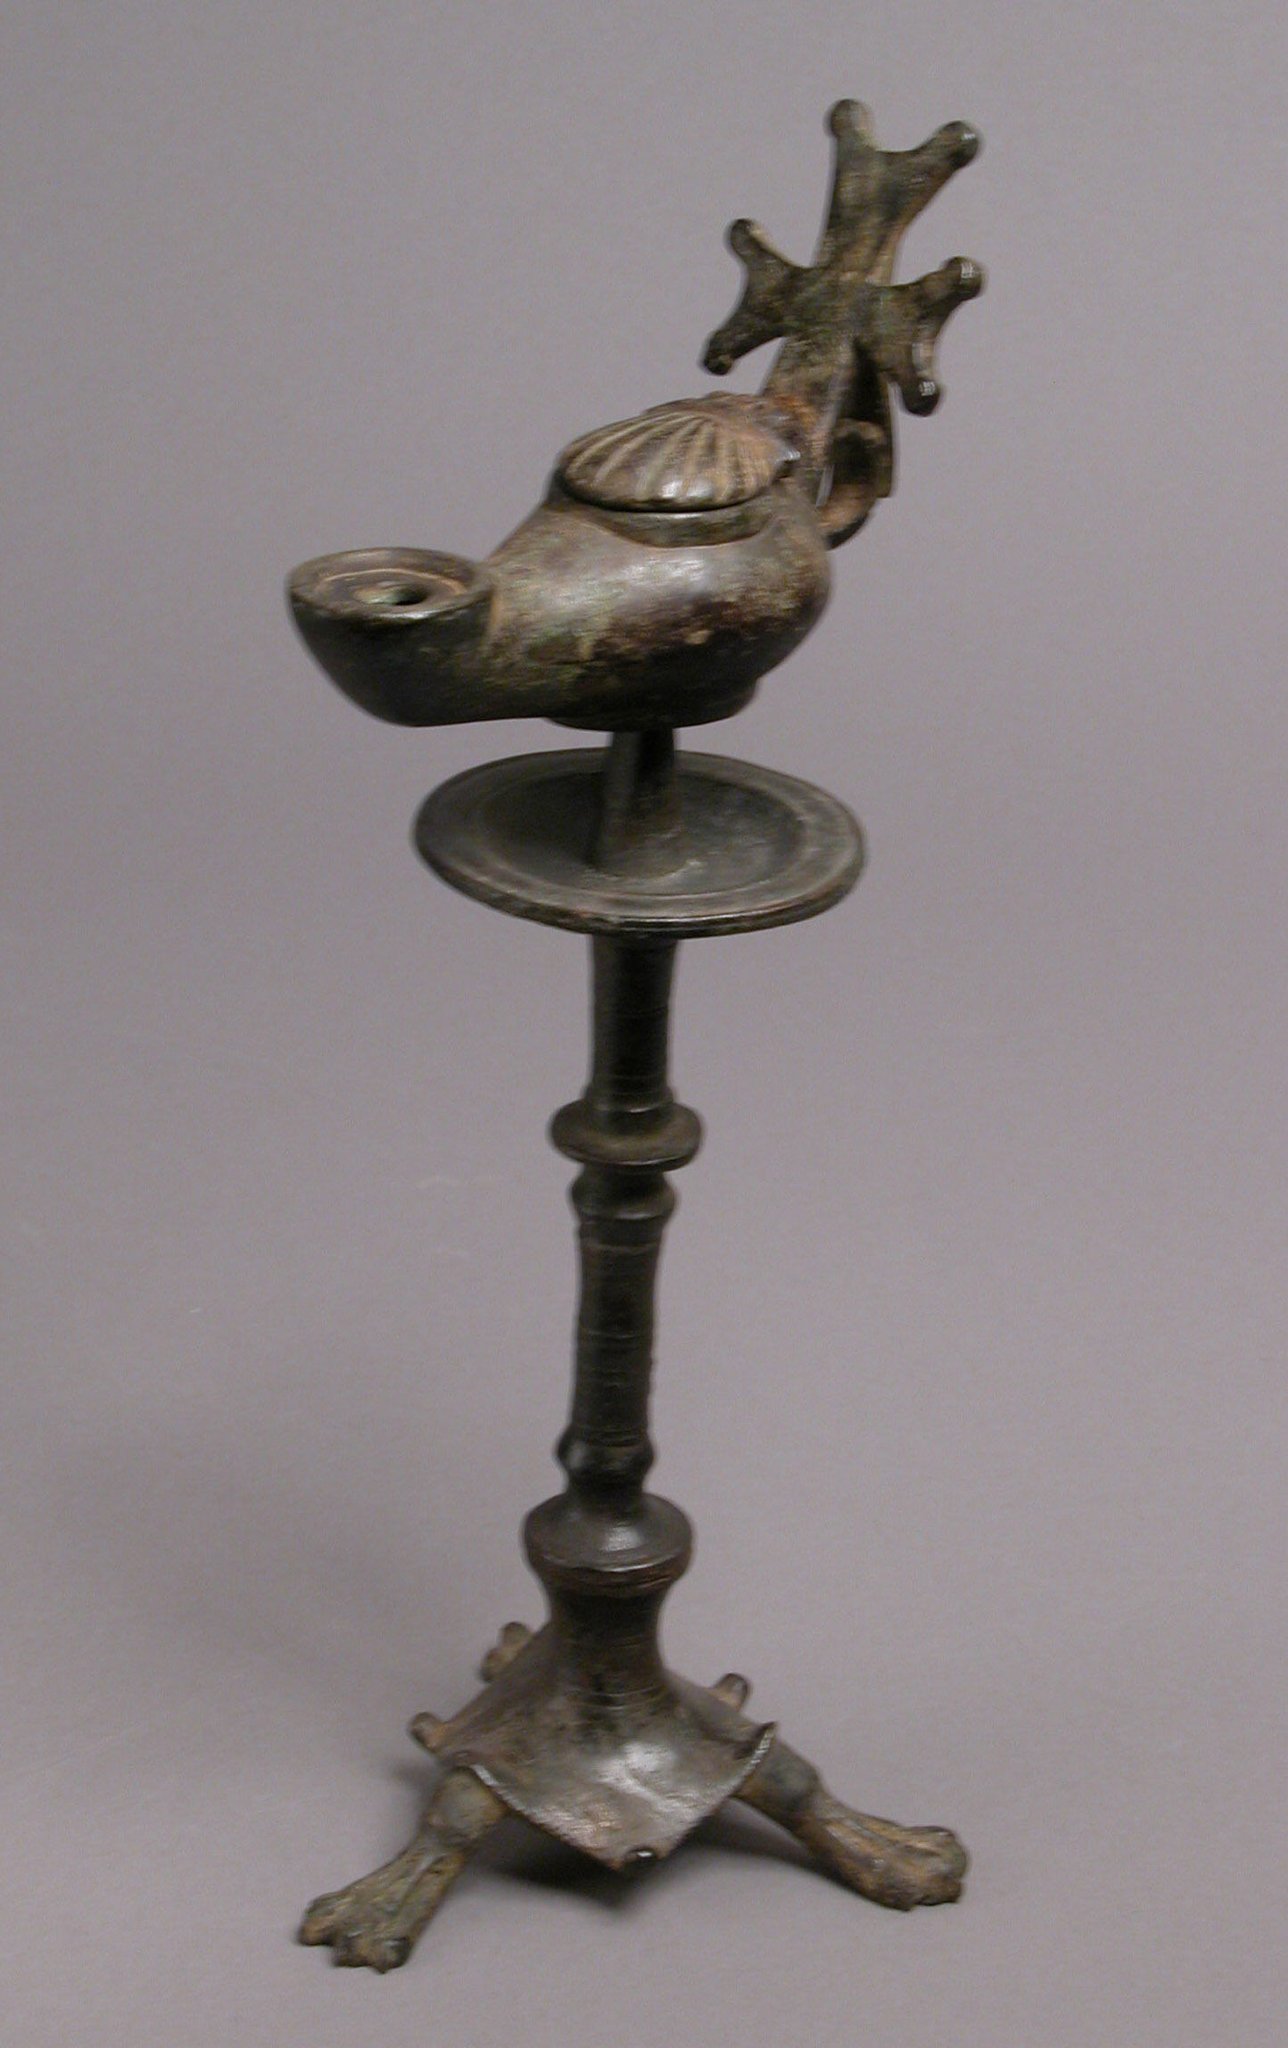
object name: lamp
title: Standing Lamp with a Cross on a Pricket Stand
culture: byzantine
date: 301-500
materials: copper alloy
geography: syria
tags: cross